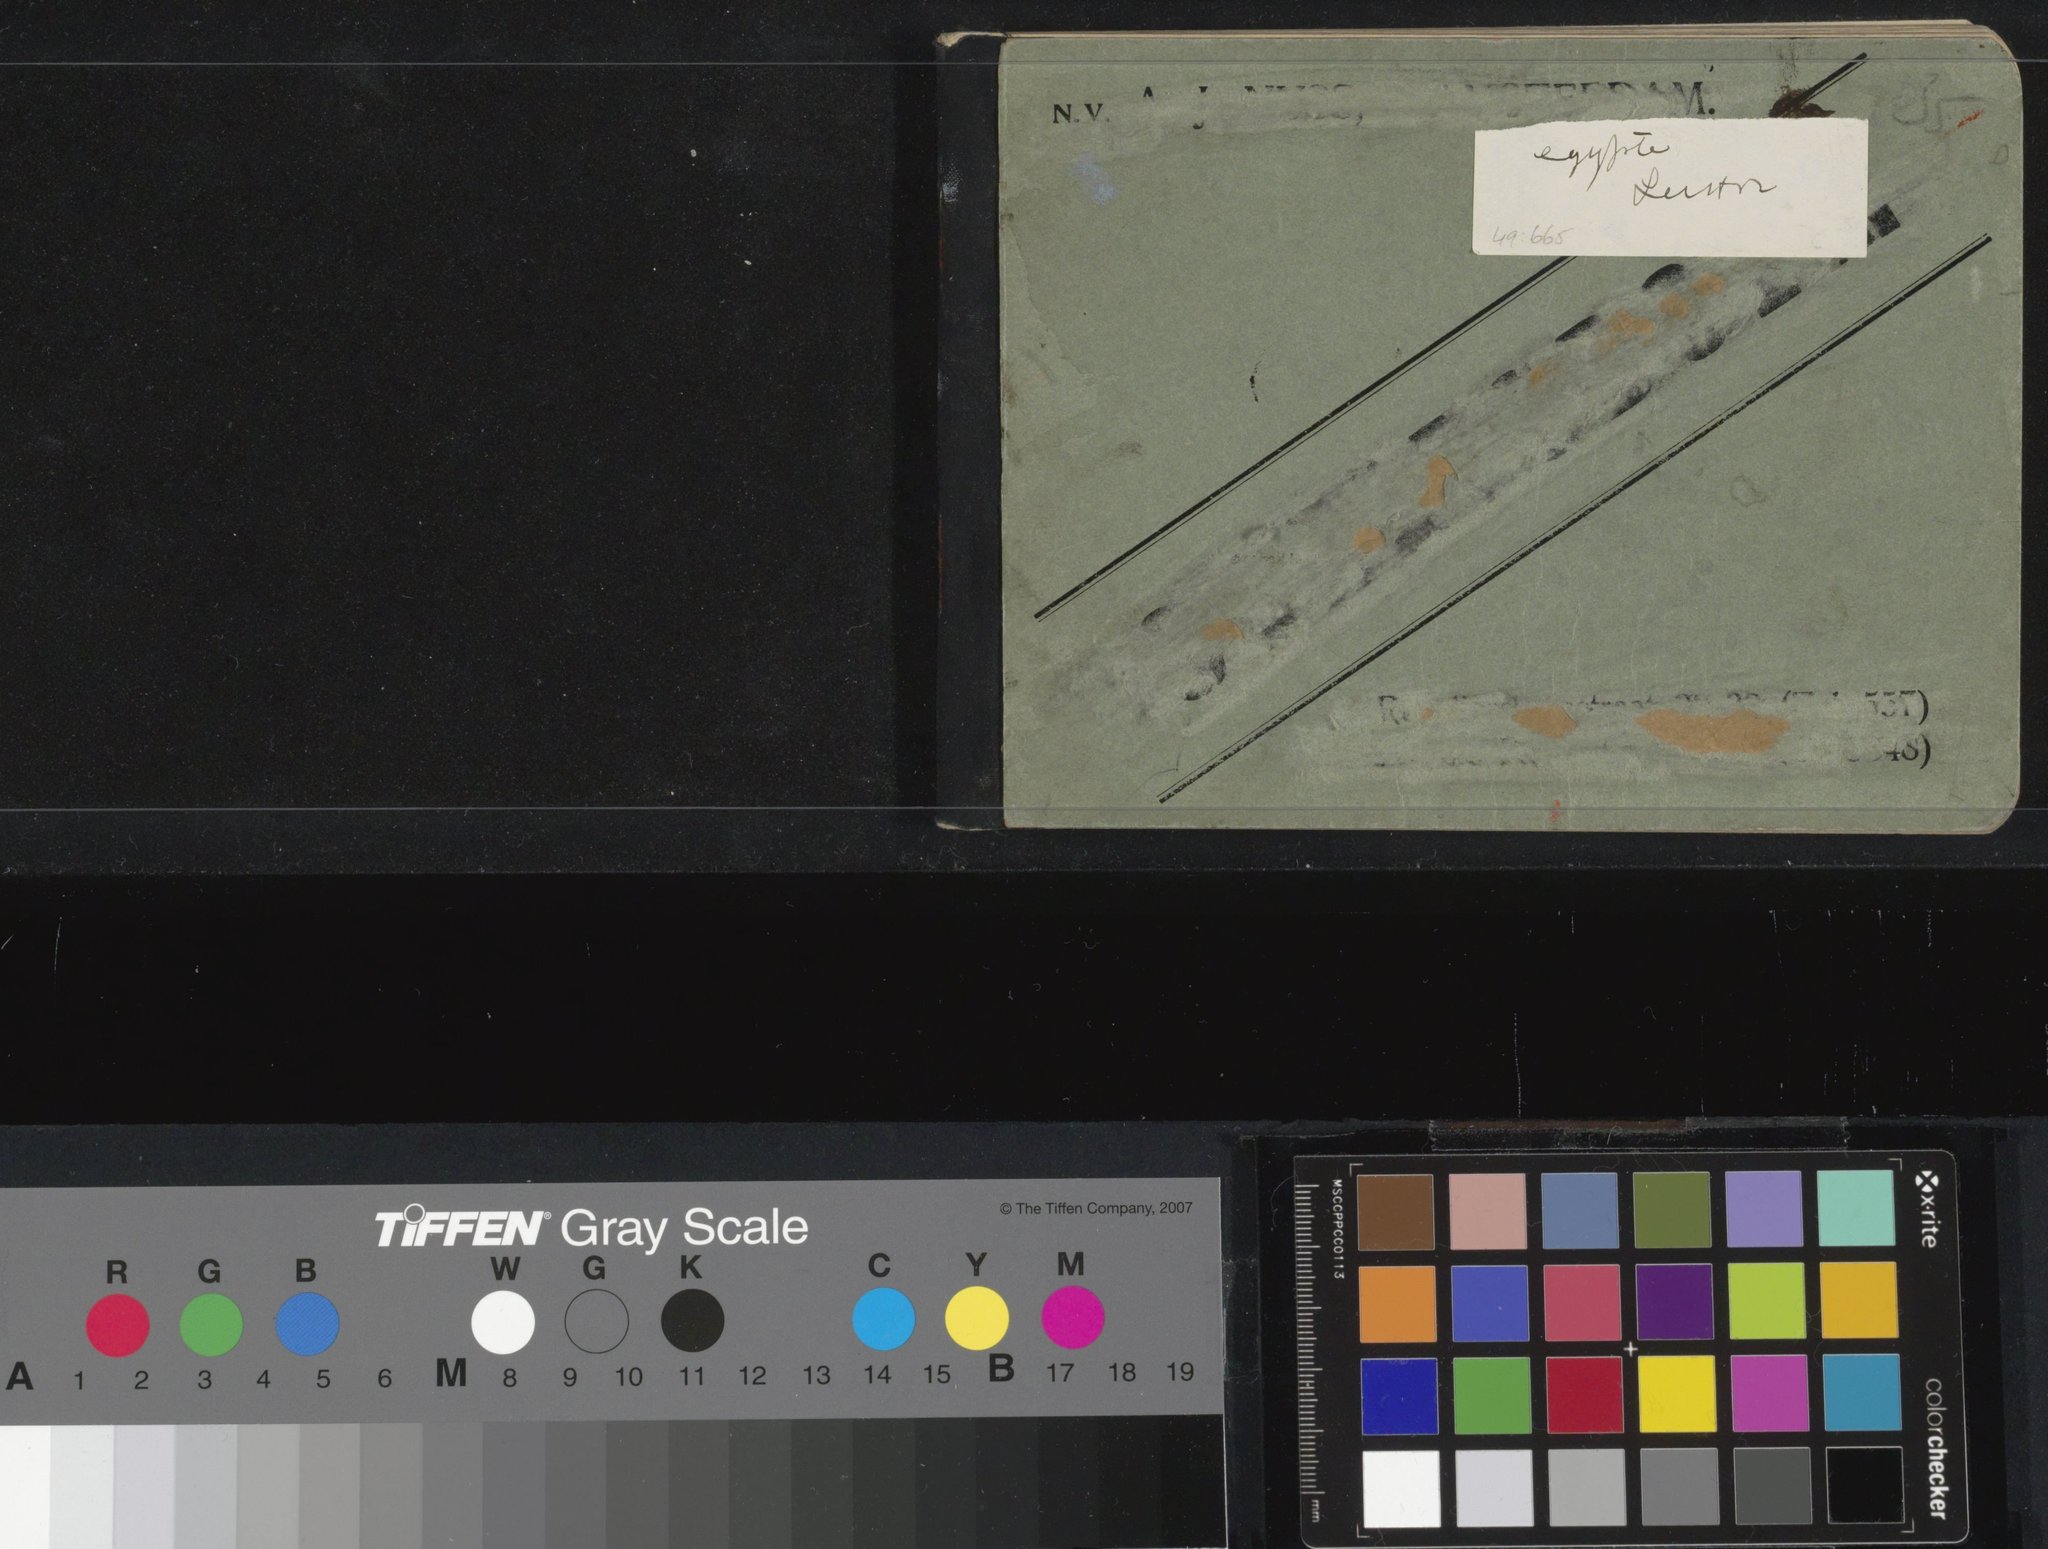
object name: sketchbook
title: Schetsboek met 28 bladen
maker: marius bauer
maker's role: draughtsman, print maker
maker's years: 1867-1932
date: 1919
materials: cardboard, chalk, linen, paper, watercolor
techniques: brush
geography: luxor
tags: temple, shrine ~ egyptian religion, africans, desert, street (+ city(-scape) with figures, staffage)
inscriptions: collector's mark: Lugt 2228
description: Schetsboek bestaande uit 28 bladen met schetsen gemaakt tijdens een reis in Egypte met straatscènes in Luxor, tempels en woestijnlandschappen met waterdragers.